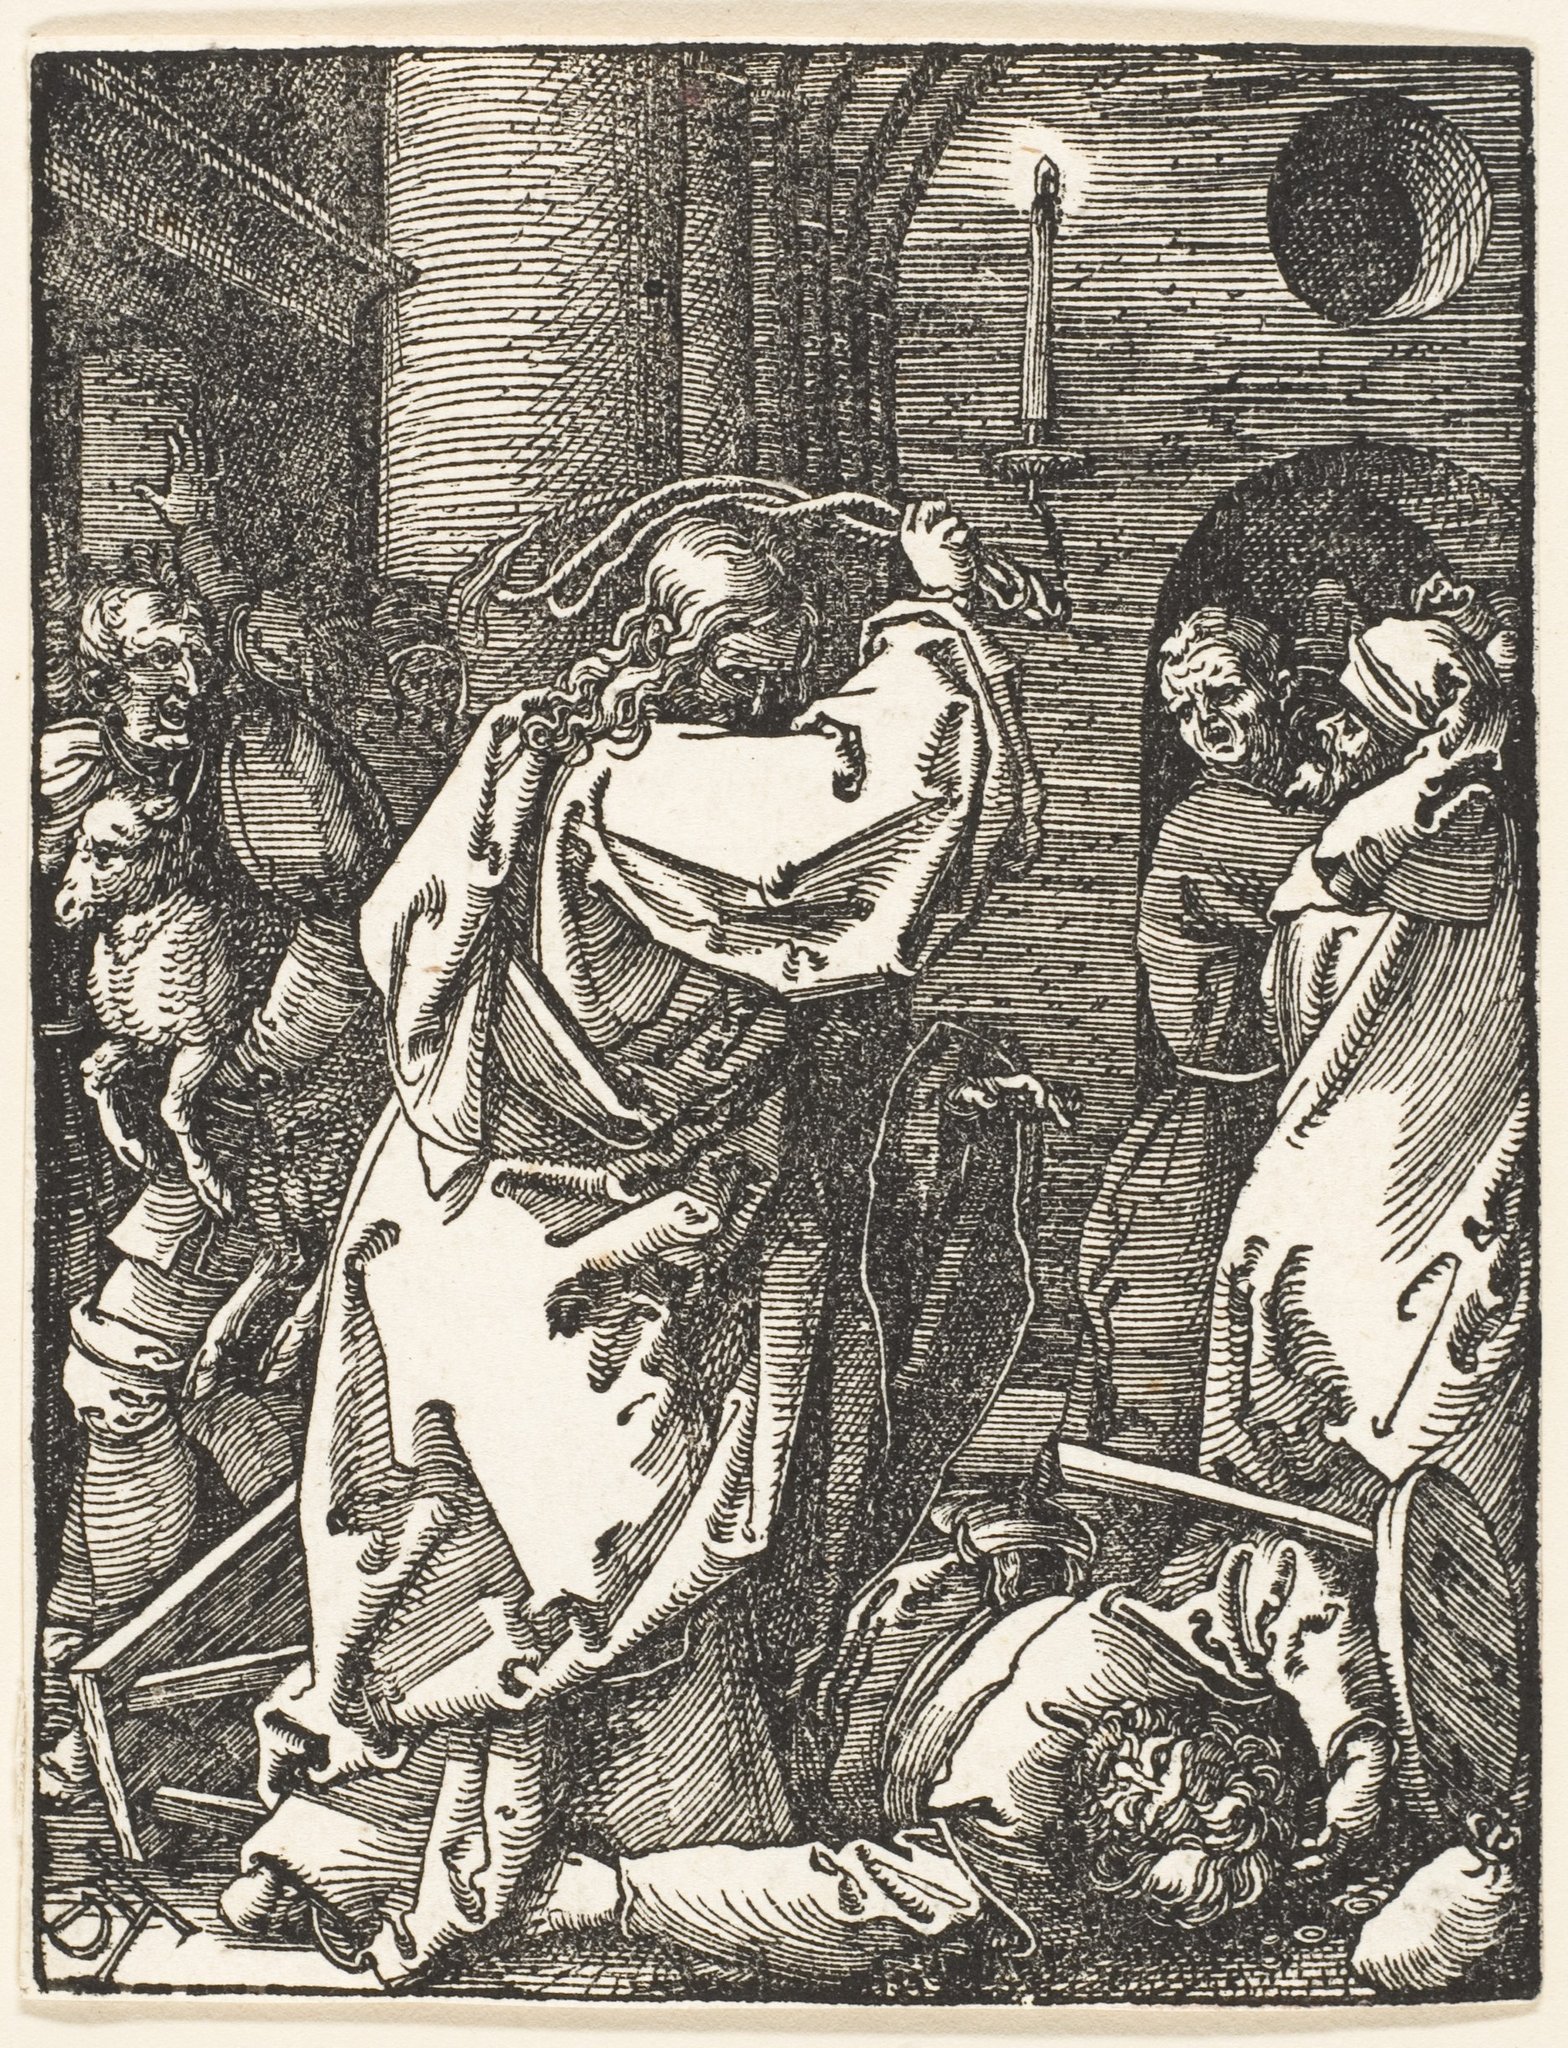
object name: print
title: Christ Expelling the Money Lenders, from "The Small Passion"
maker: albrecht dürer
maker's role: artist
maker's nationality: german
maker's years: 1471-1528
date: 1508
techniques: woodcut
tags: men,christ